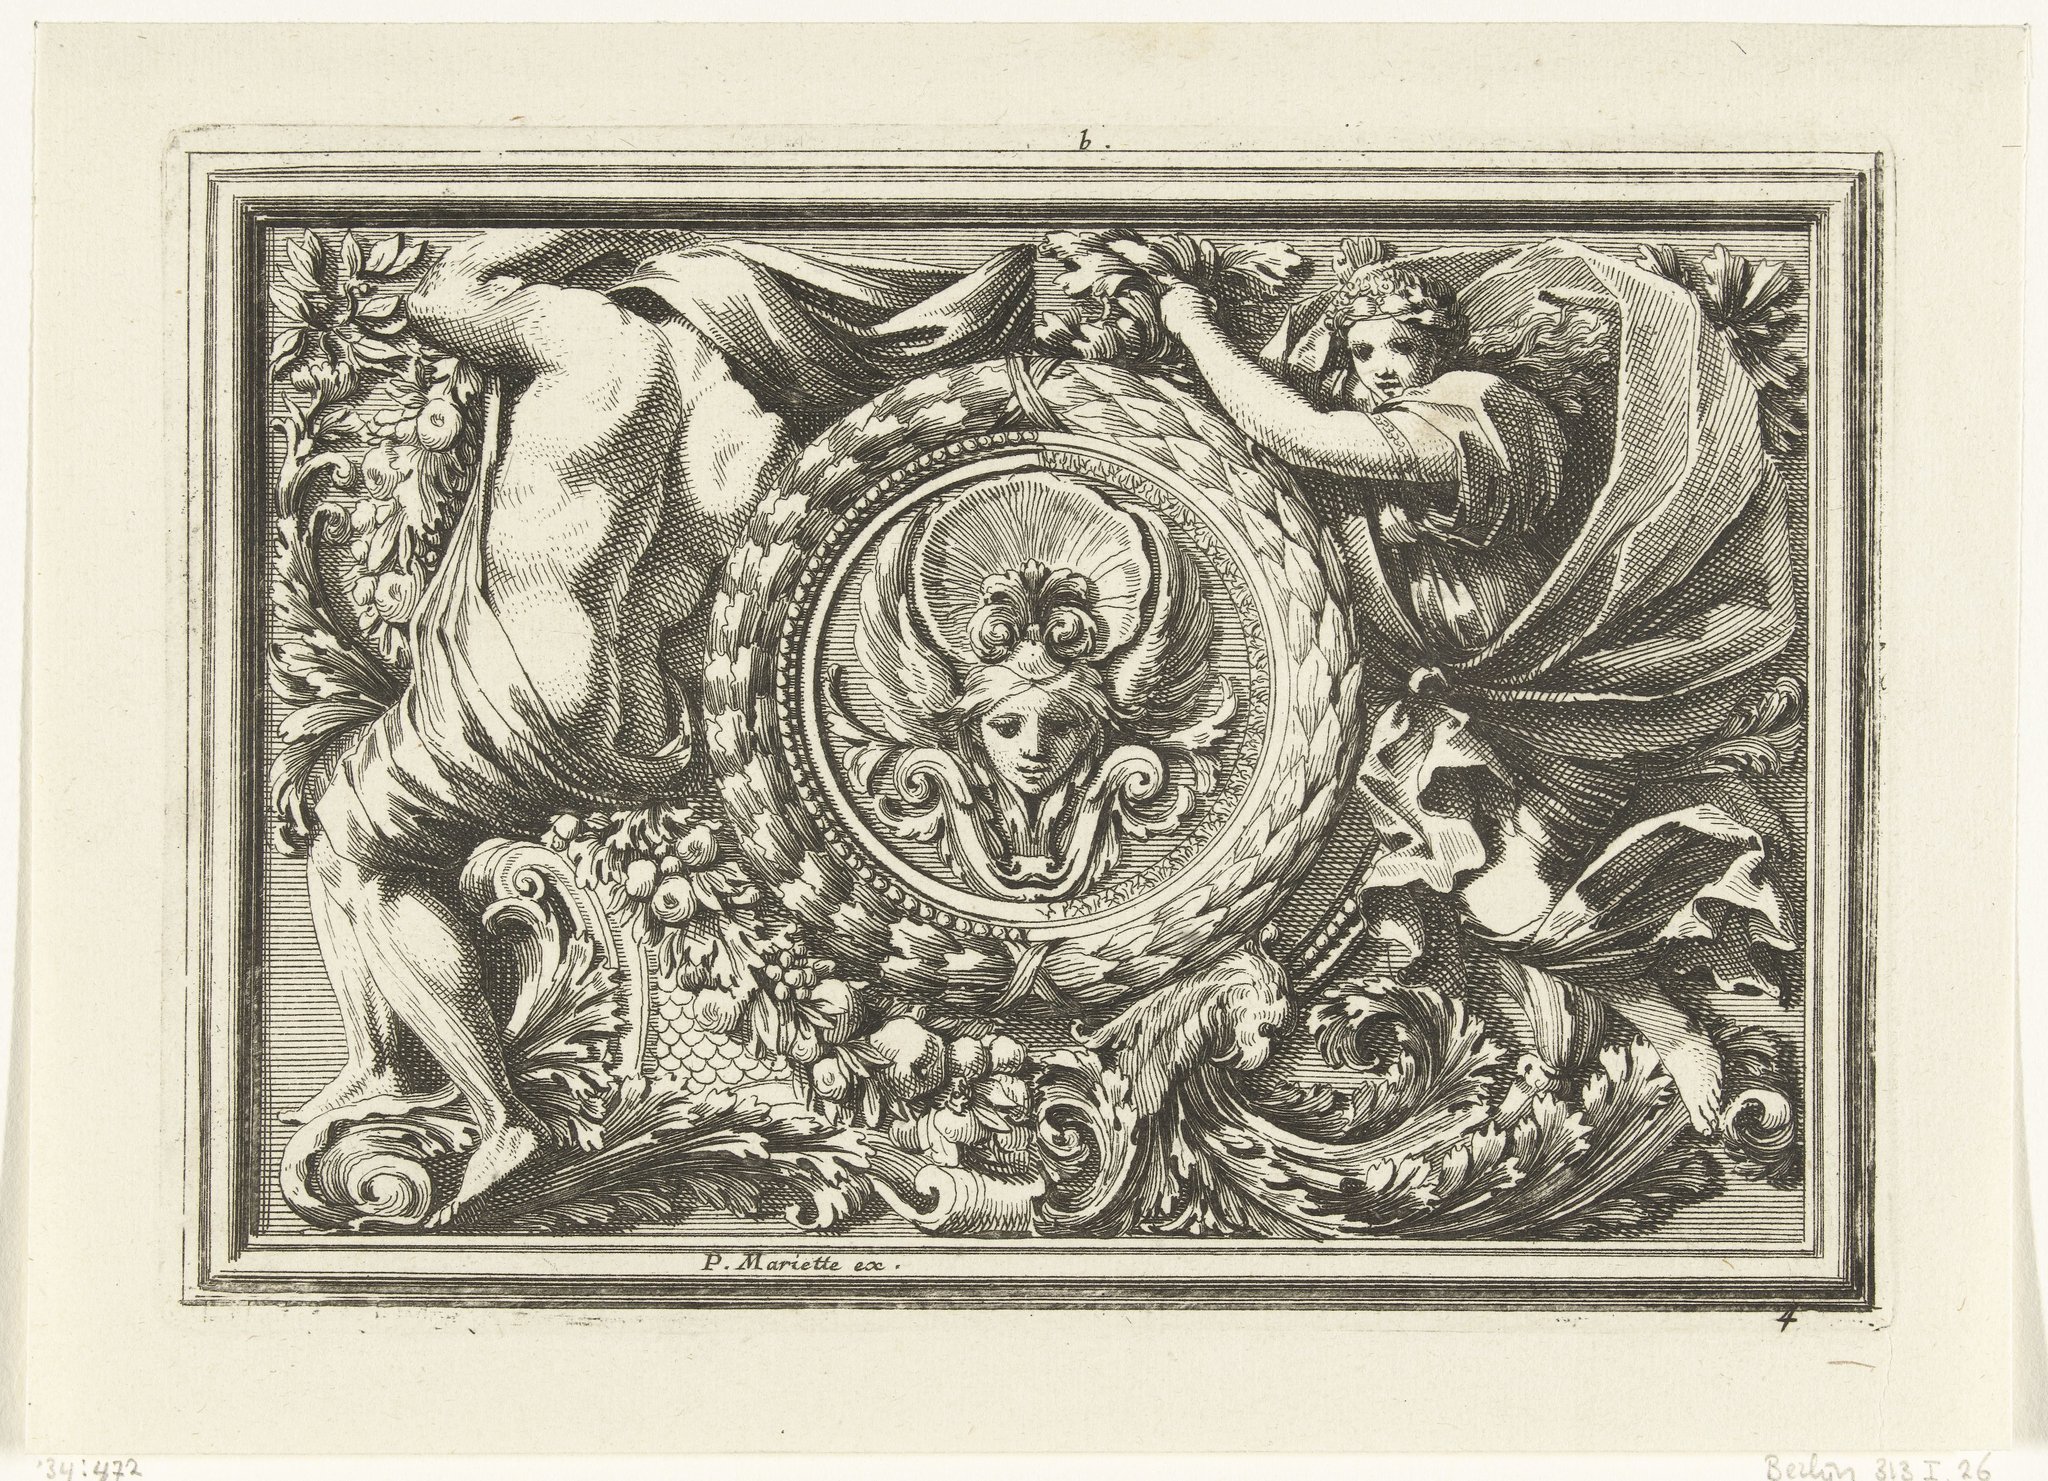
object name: print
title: Paneel met masker in rond medaillon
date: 1667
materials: paper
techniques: etching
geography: paris